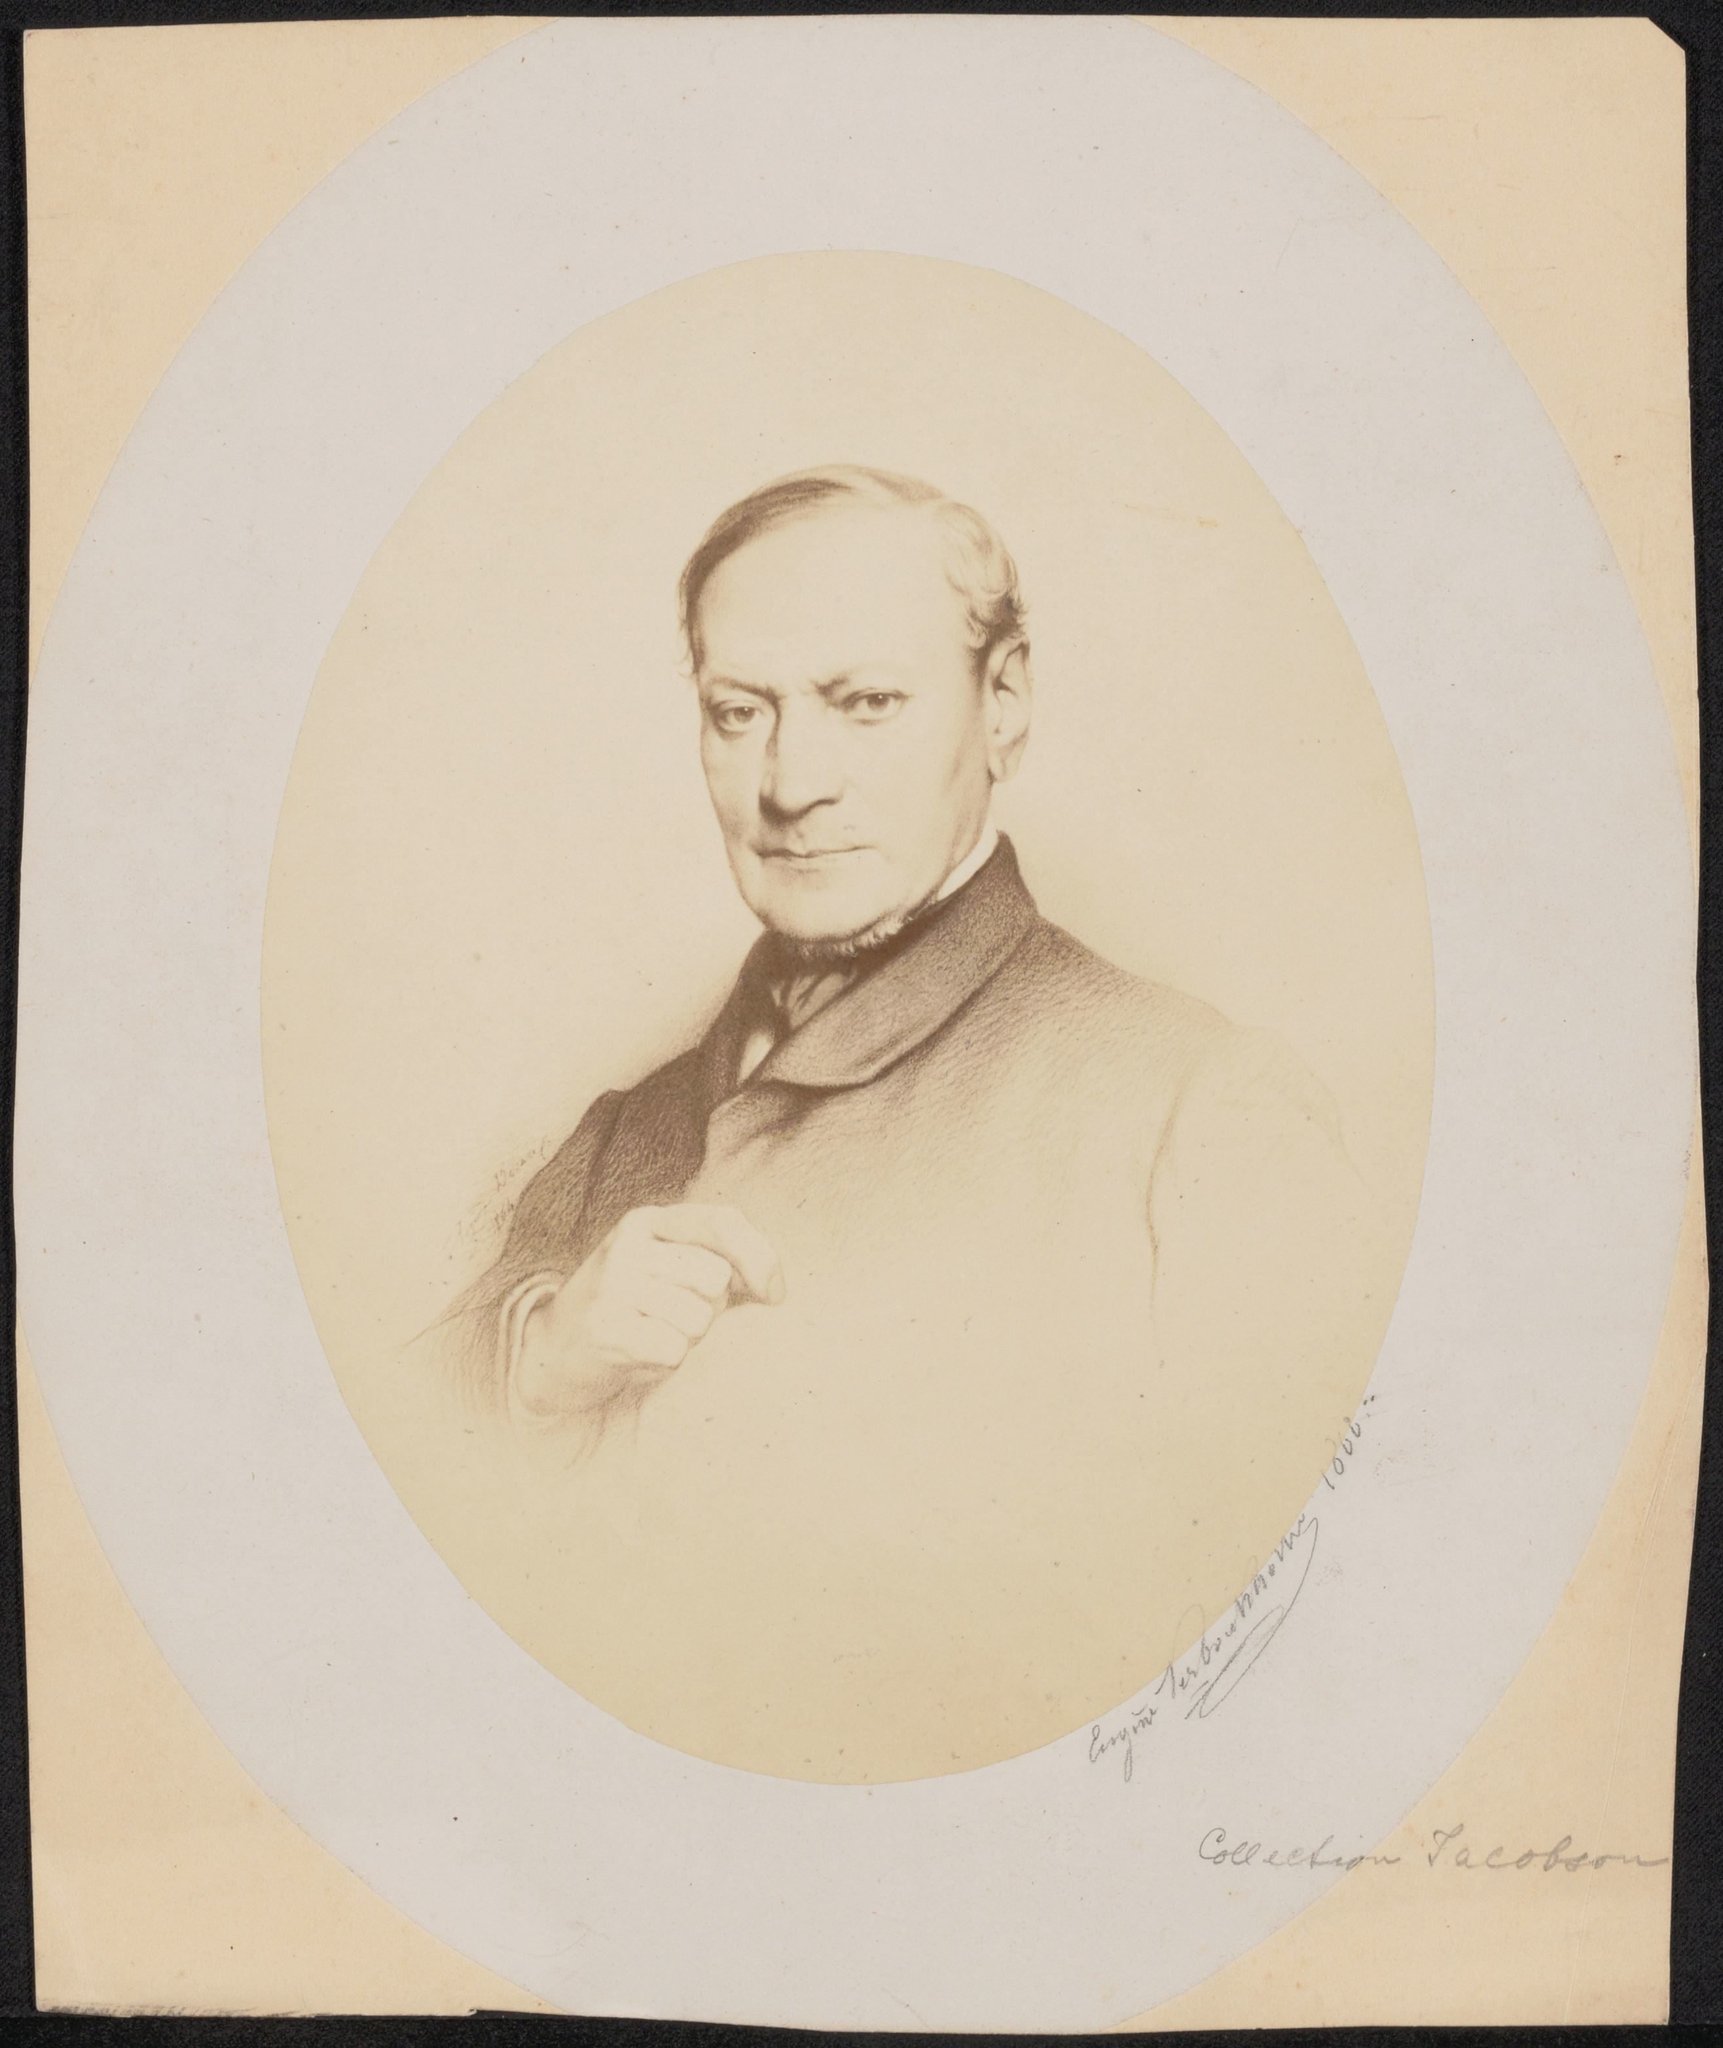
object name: photograph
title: Portret in ovaal van Eugène Verboeckhoven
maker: Anonymous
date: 1866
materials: cardboard, photographic support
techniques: photography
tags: painter, print maker, draughtsman, printer, eugène verboeckhoven, family life